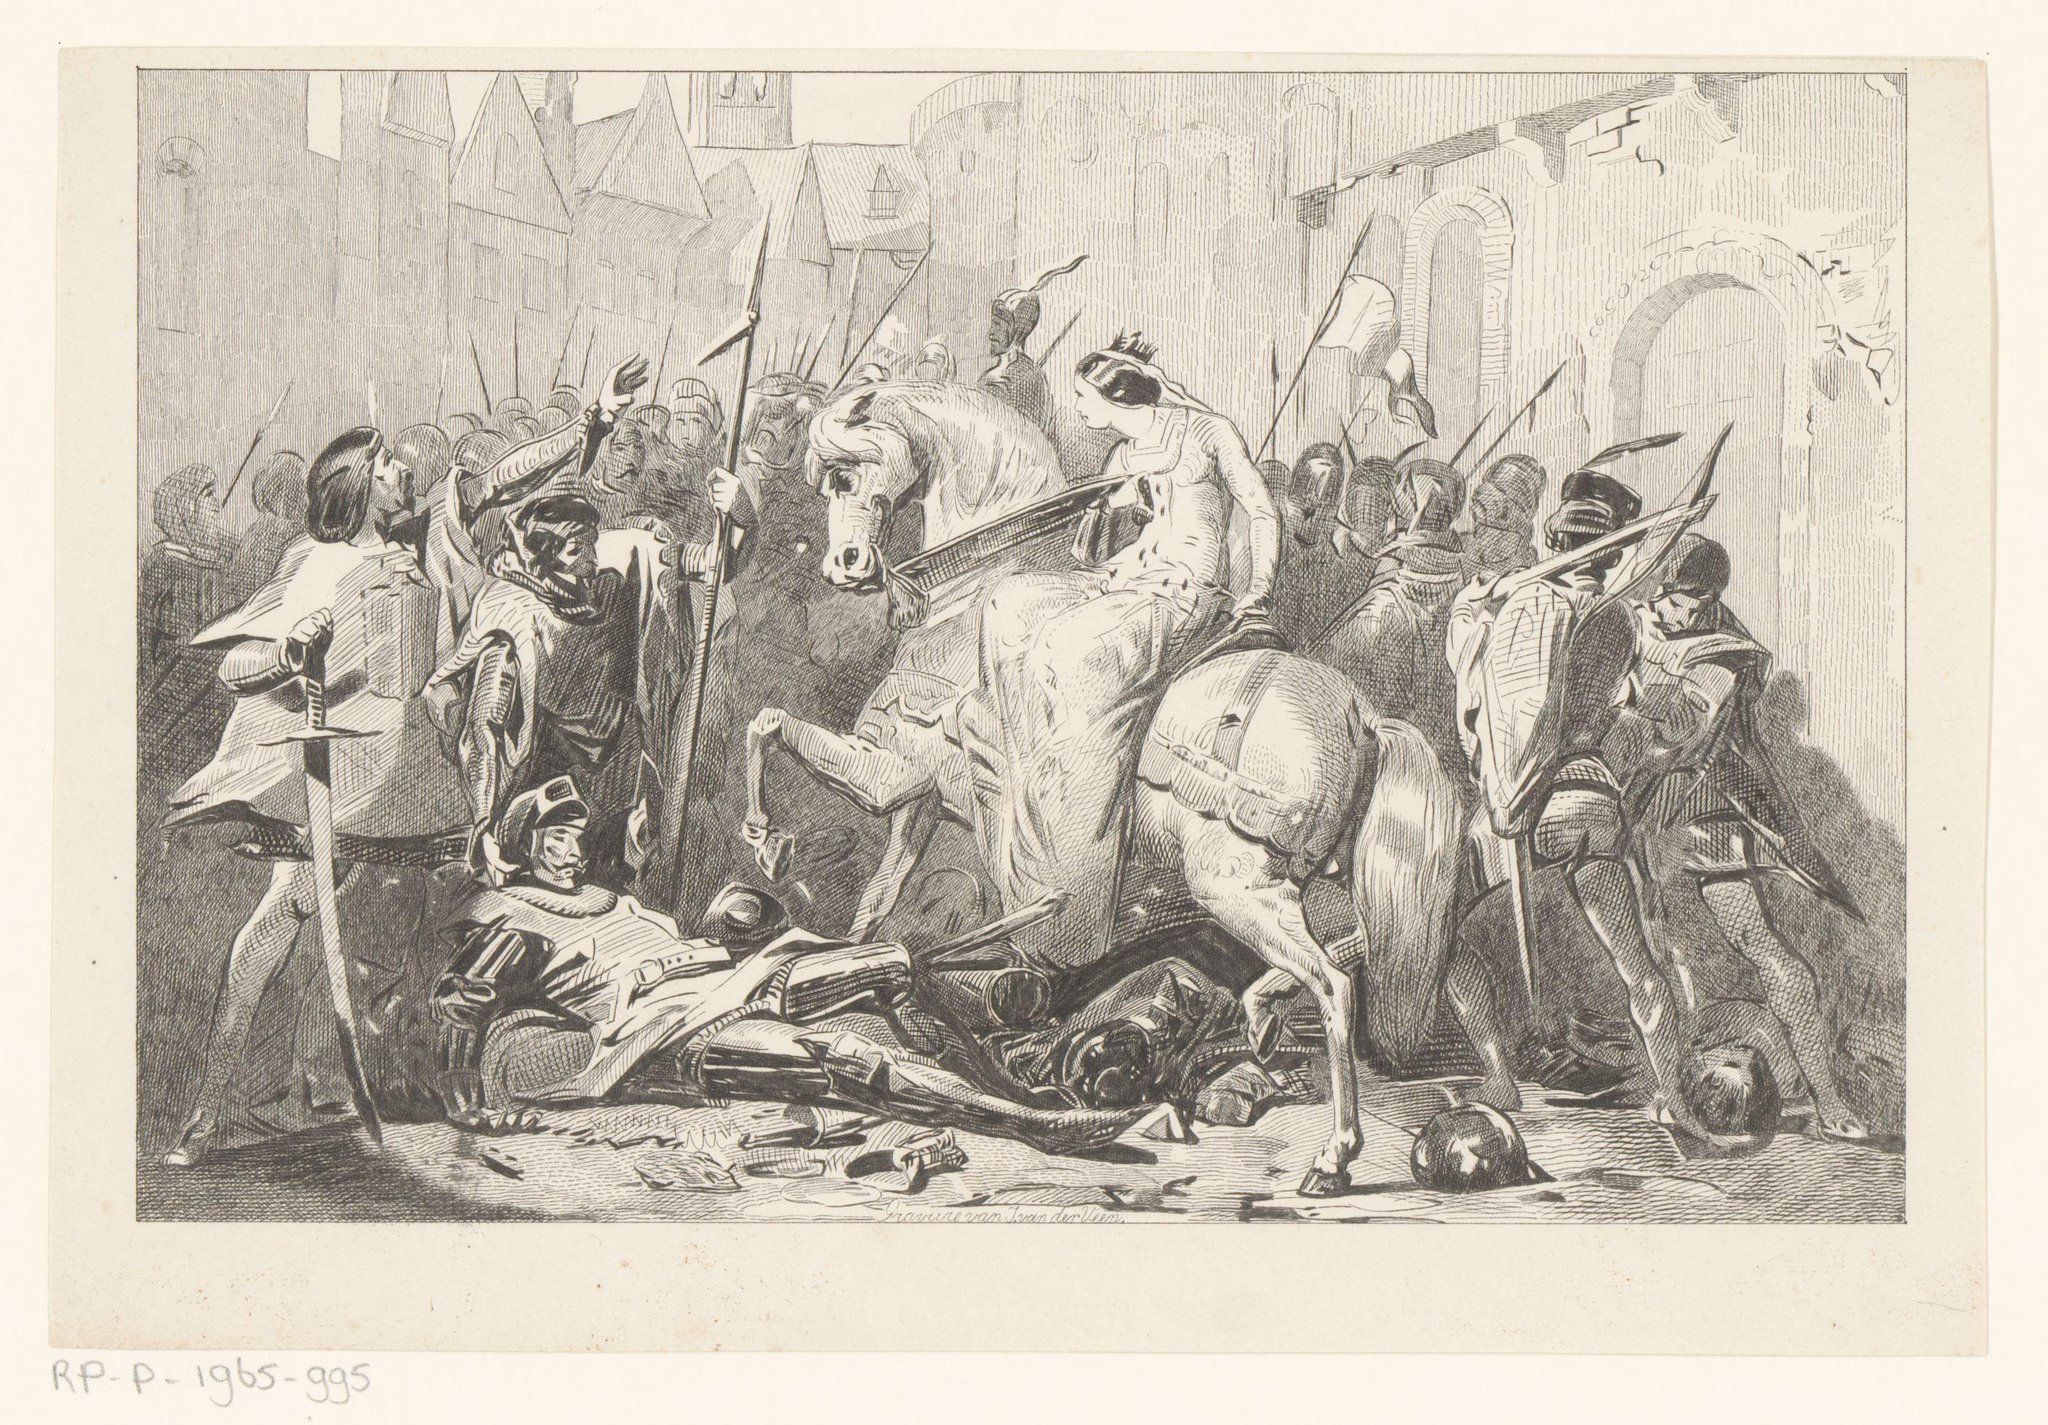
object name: print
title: Jacoba van Beieren stelt zich aan het hoofd van de Hoeken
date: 1855-1861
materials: paper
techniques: lithograph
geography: netherlands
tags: jacoba of bavaria (countess of hainaut), battle, fighting in general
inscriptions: collector's mark: Lugt 2228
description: Proefdruk voor prent uit: Lennep, Jacob van. De geschiedenis des vaderlands in schetsen en afbeeldingen. Amsterdam: Binger & Zonen, M.H., 1855-1861.